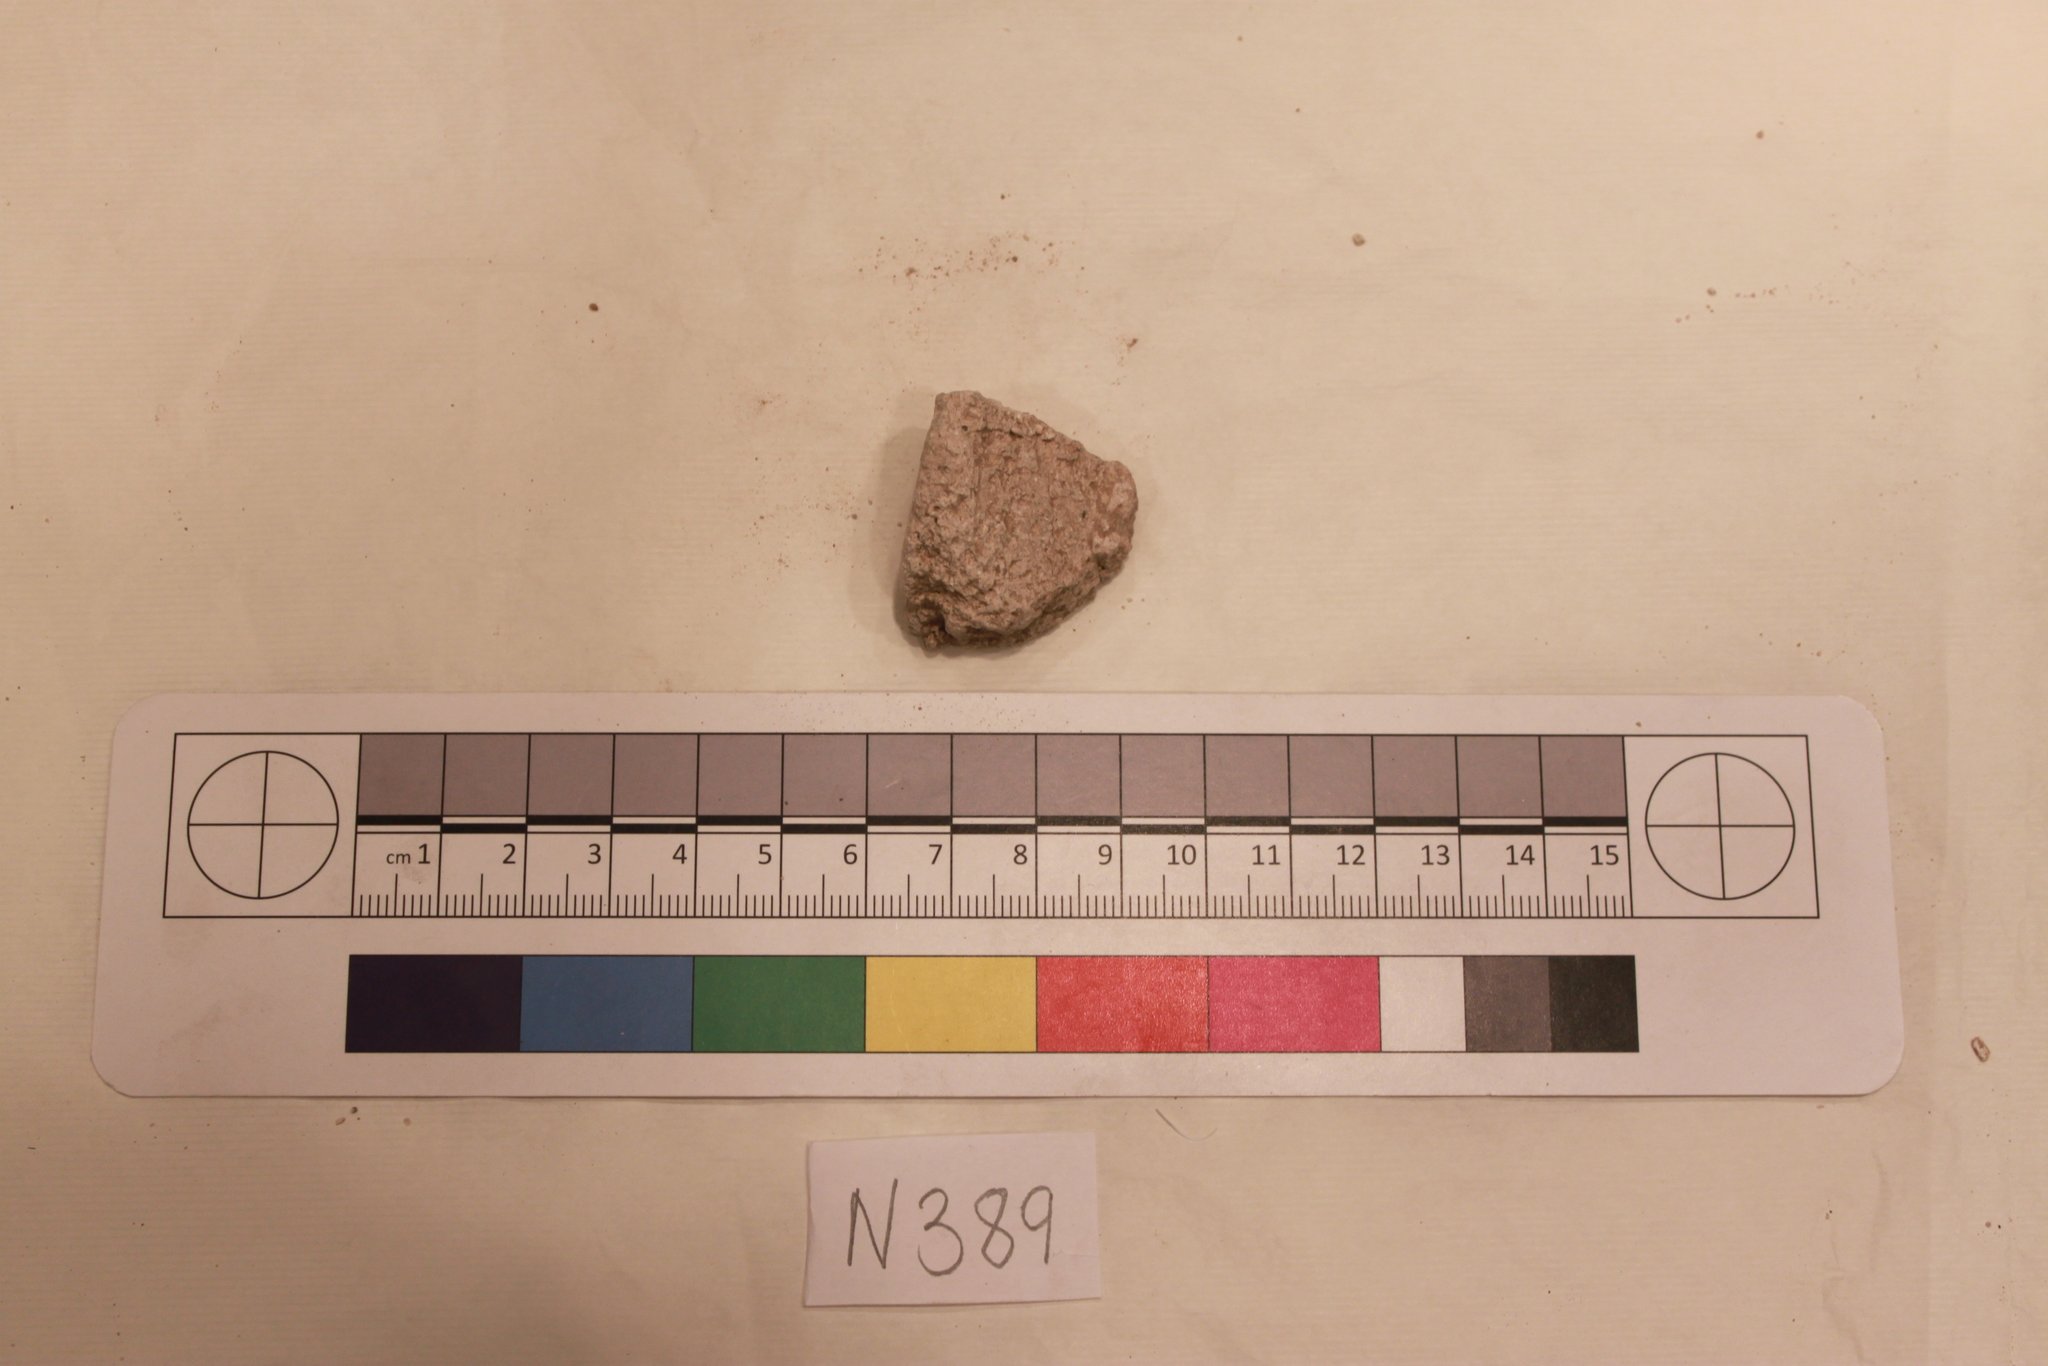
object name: fragment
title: Stucco Fragment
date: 701-1200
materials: plaster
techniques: carving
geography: iran